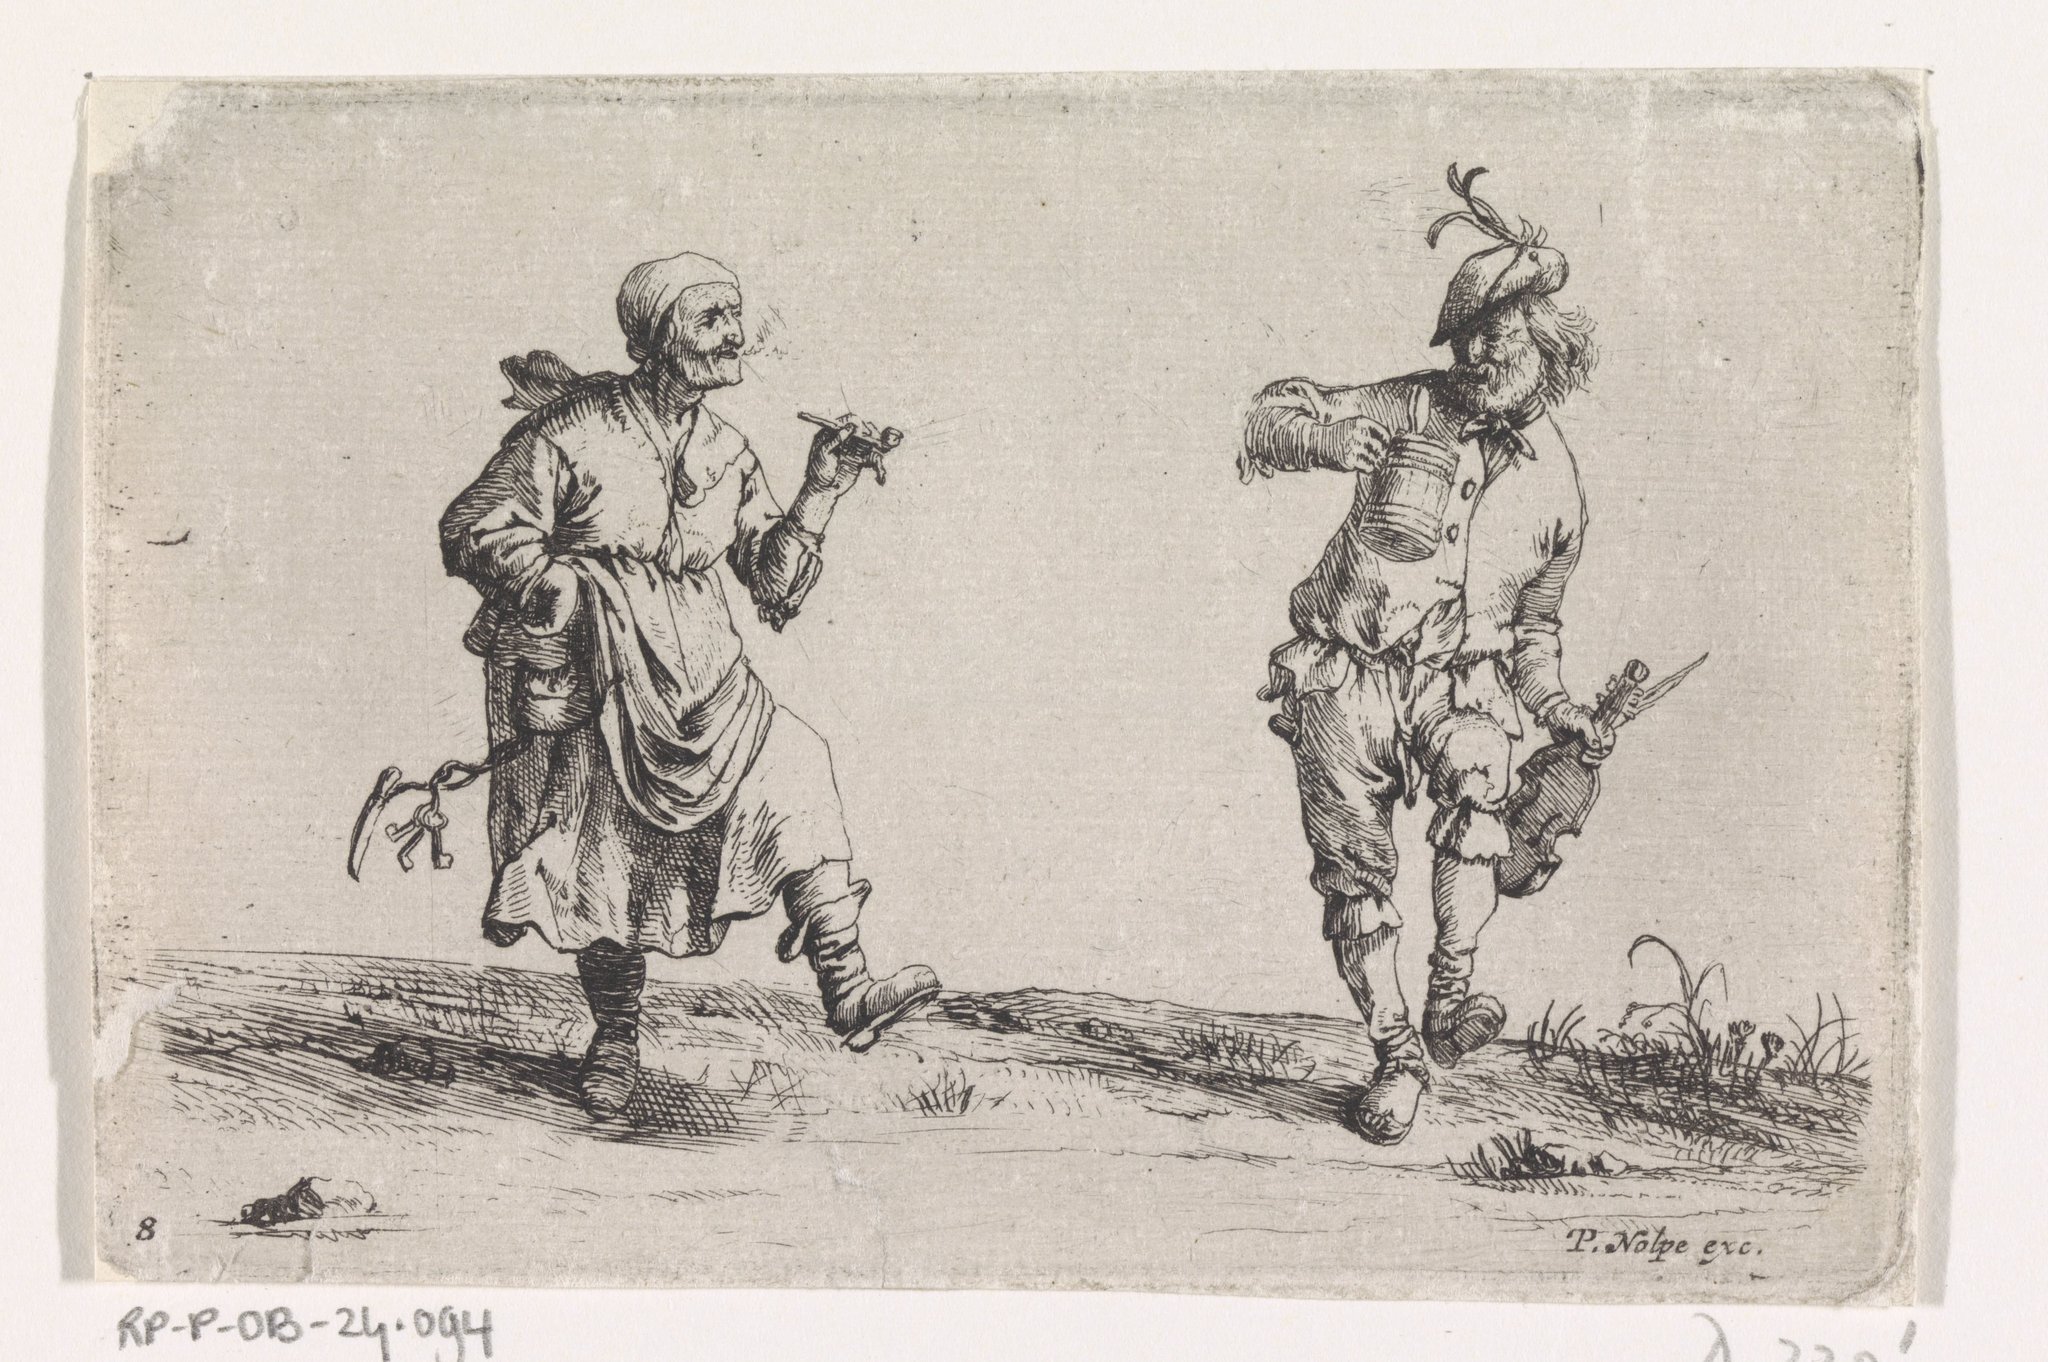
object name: print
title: Scènes uit het boerenleven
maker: pieter nolpe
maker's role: draughtsman, print maker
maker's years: 1613-1653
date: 1623-1653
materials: paper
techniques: engraving, etching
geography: amsterdam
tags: dancing, violin, fiddle, pipe ~ tobacco, farmers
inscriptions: collector's mark: Lugt 2228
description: Een boerin en een boer dansen naast elkaar in het gras. De boerin rookt een pijpje en heeft een sleutelbos en een mes aan haar kleed hangen. De boer houdt een drinkkroes in de ene en een viool in de andere hand. Prent maakt deel uit van een serie met scènes uit het boerenleven.